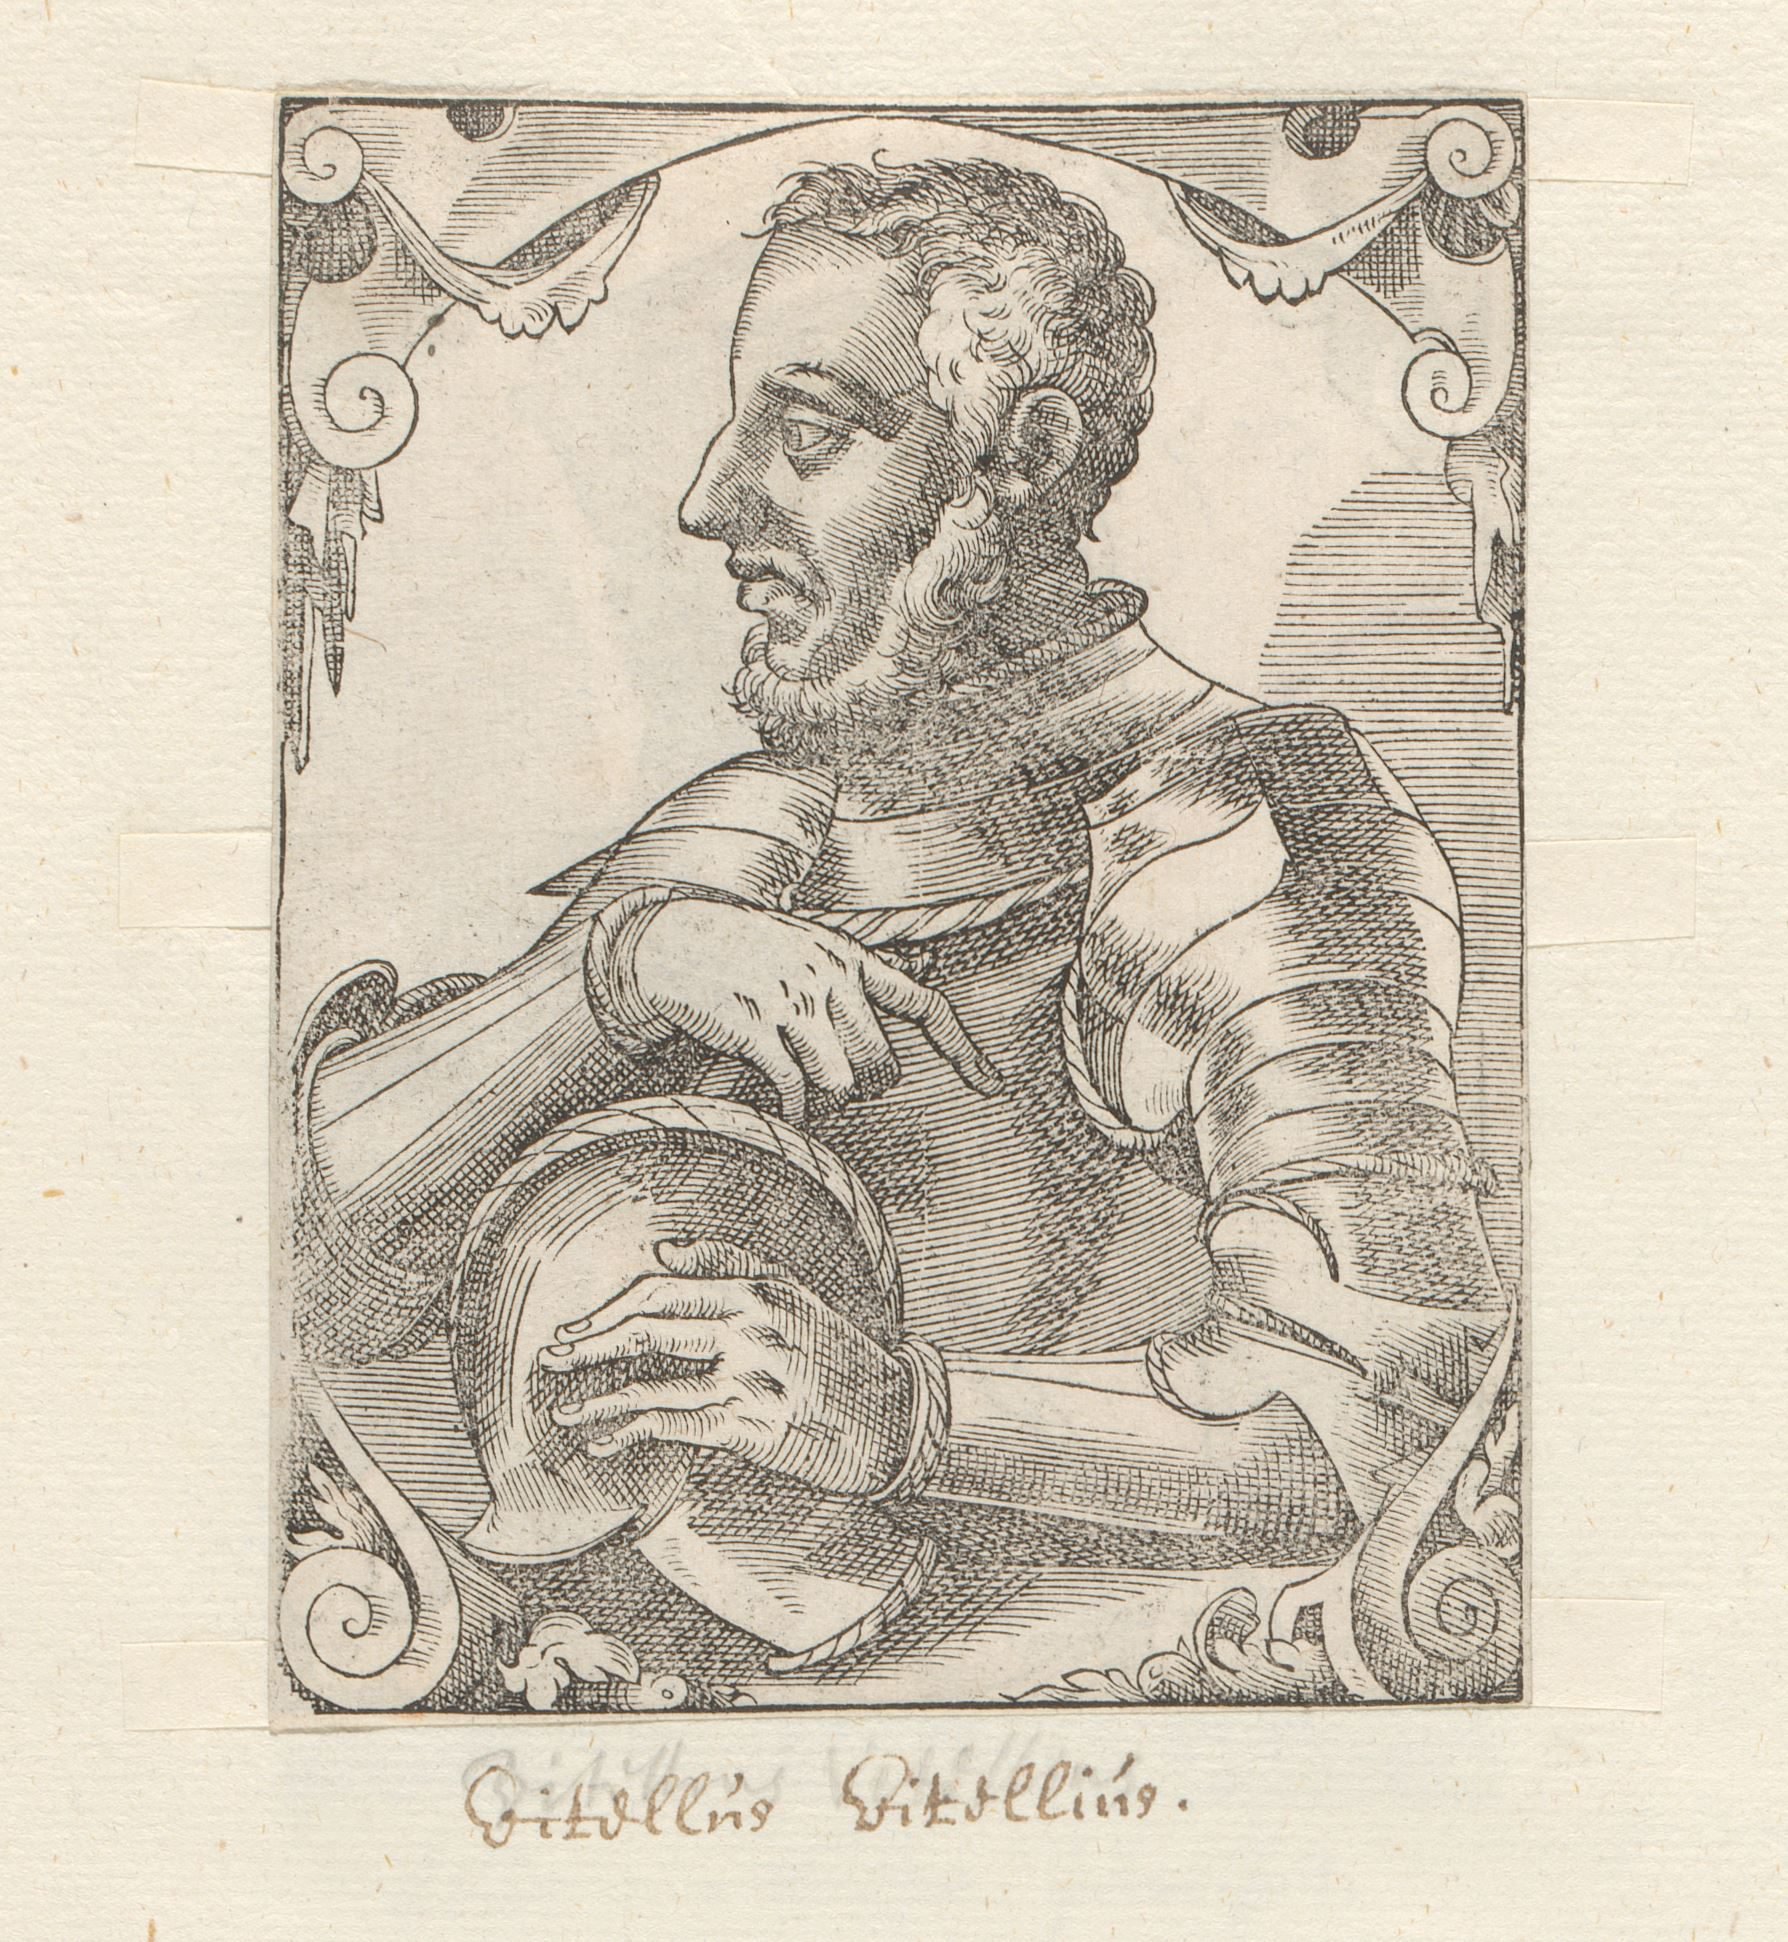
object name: album leaf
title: Portret van Vitellius Vitellius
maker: Anonymous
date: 1549-1575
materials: paper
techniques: woodcut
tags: historical persons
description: Prent gebruikt in: Giovio, Paolo. Elogia Virorum bellica virtute illustrium (...). Bazel: Peter Perna, 1575.